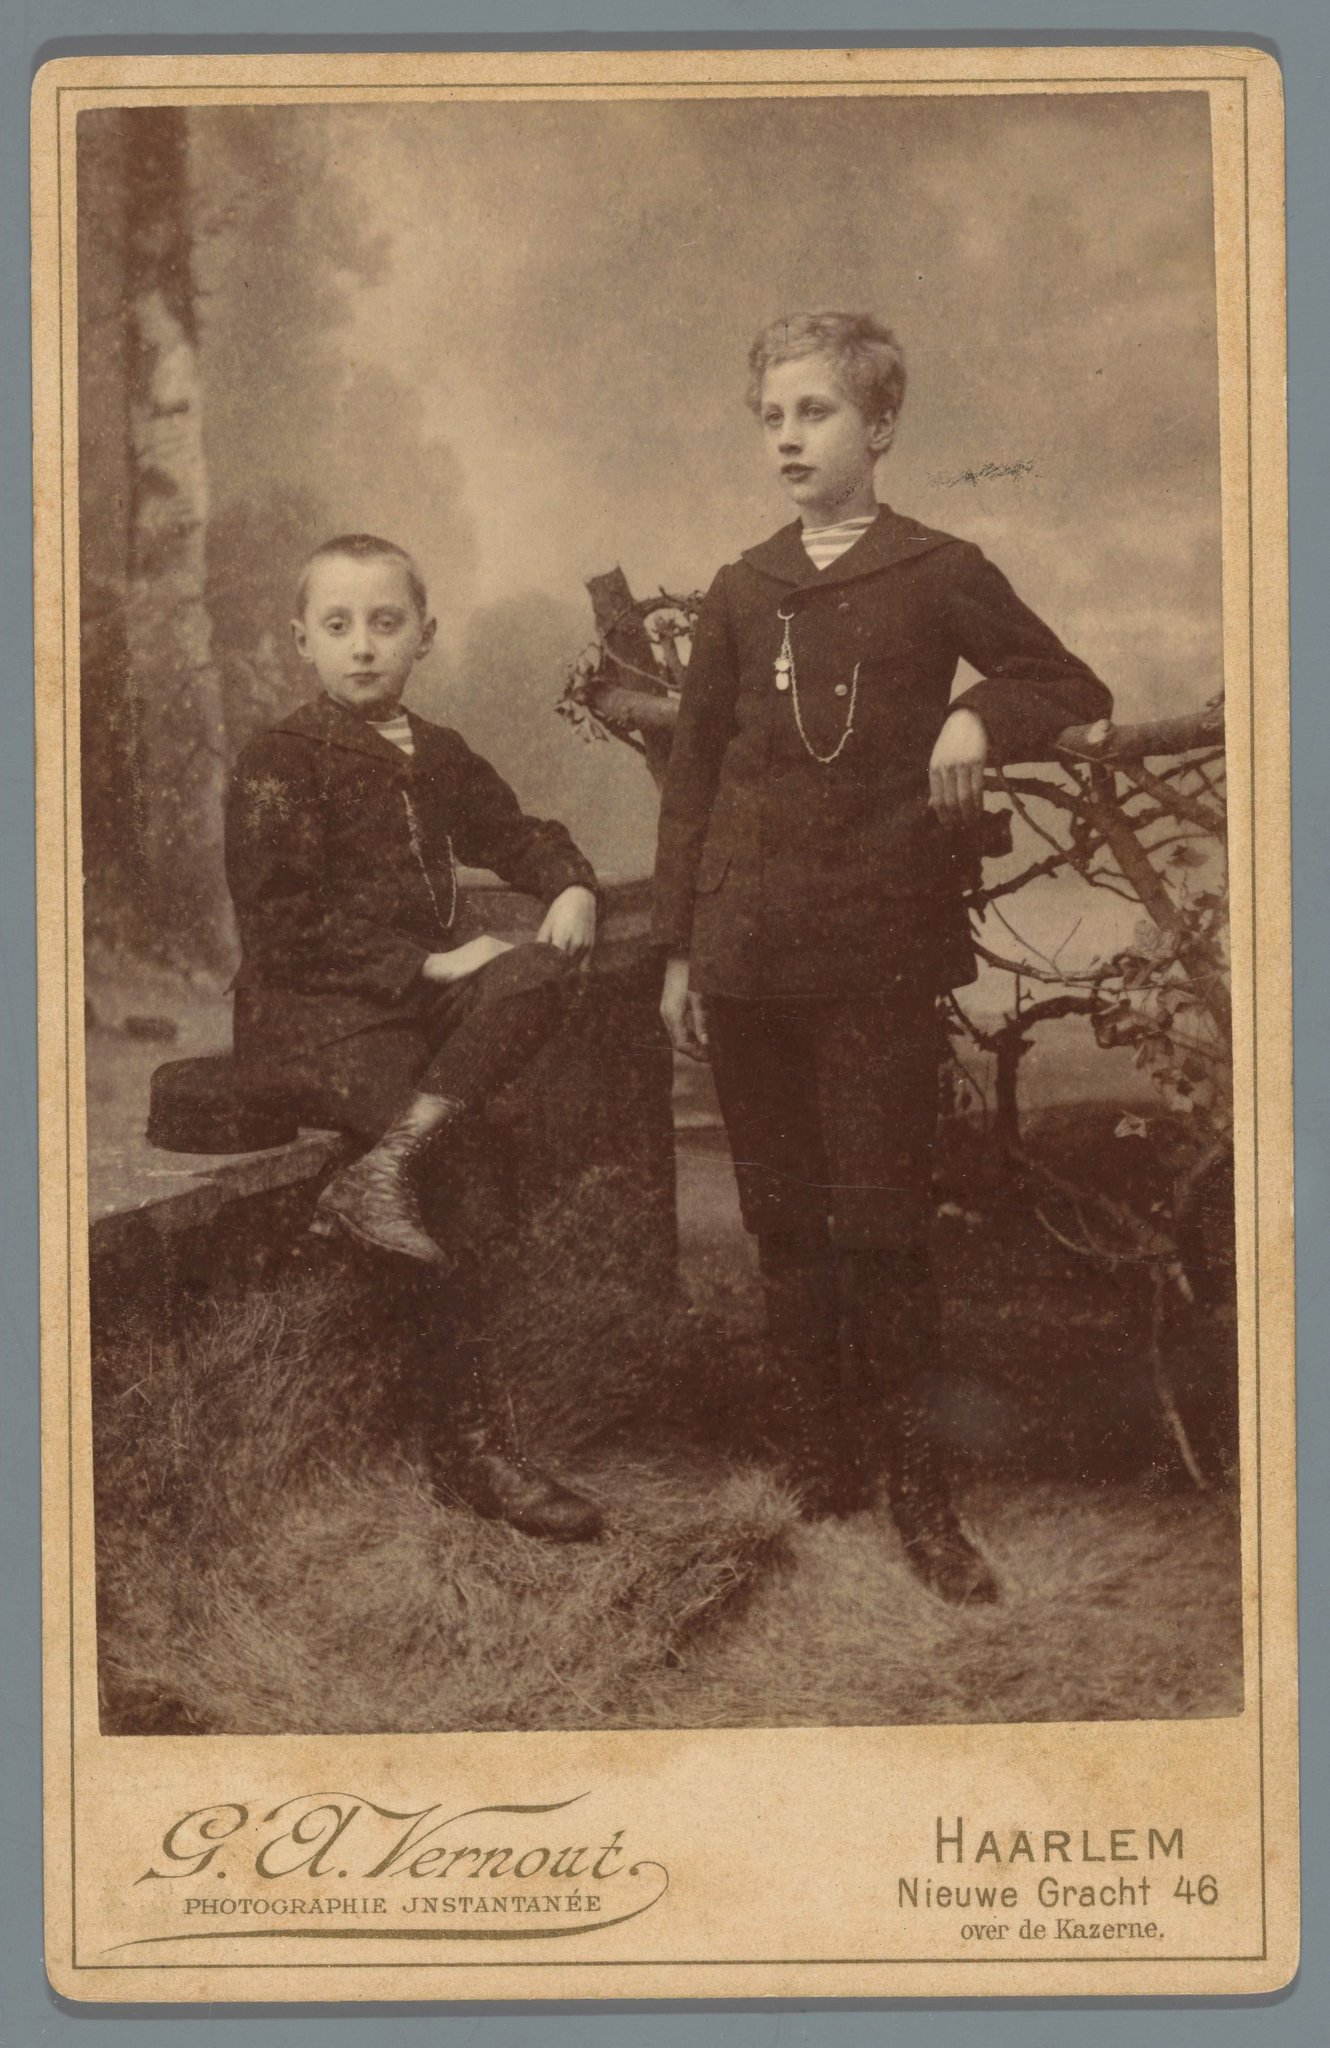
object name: cabinet photograph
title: Studioportret van twee jongens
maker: g. a. vernout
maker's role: fotograaf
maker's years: 1848-1913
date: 1875-1890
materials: cardboard, photographic support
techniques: albumen print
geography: haarlem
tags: studio ~ photographer, boy (child between toddler and youth)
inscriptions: inscription: ‘G.A. Vernout (...) Vergrootingen naar ieder portret’